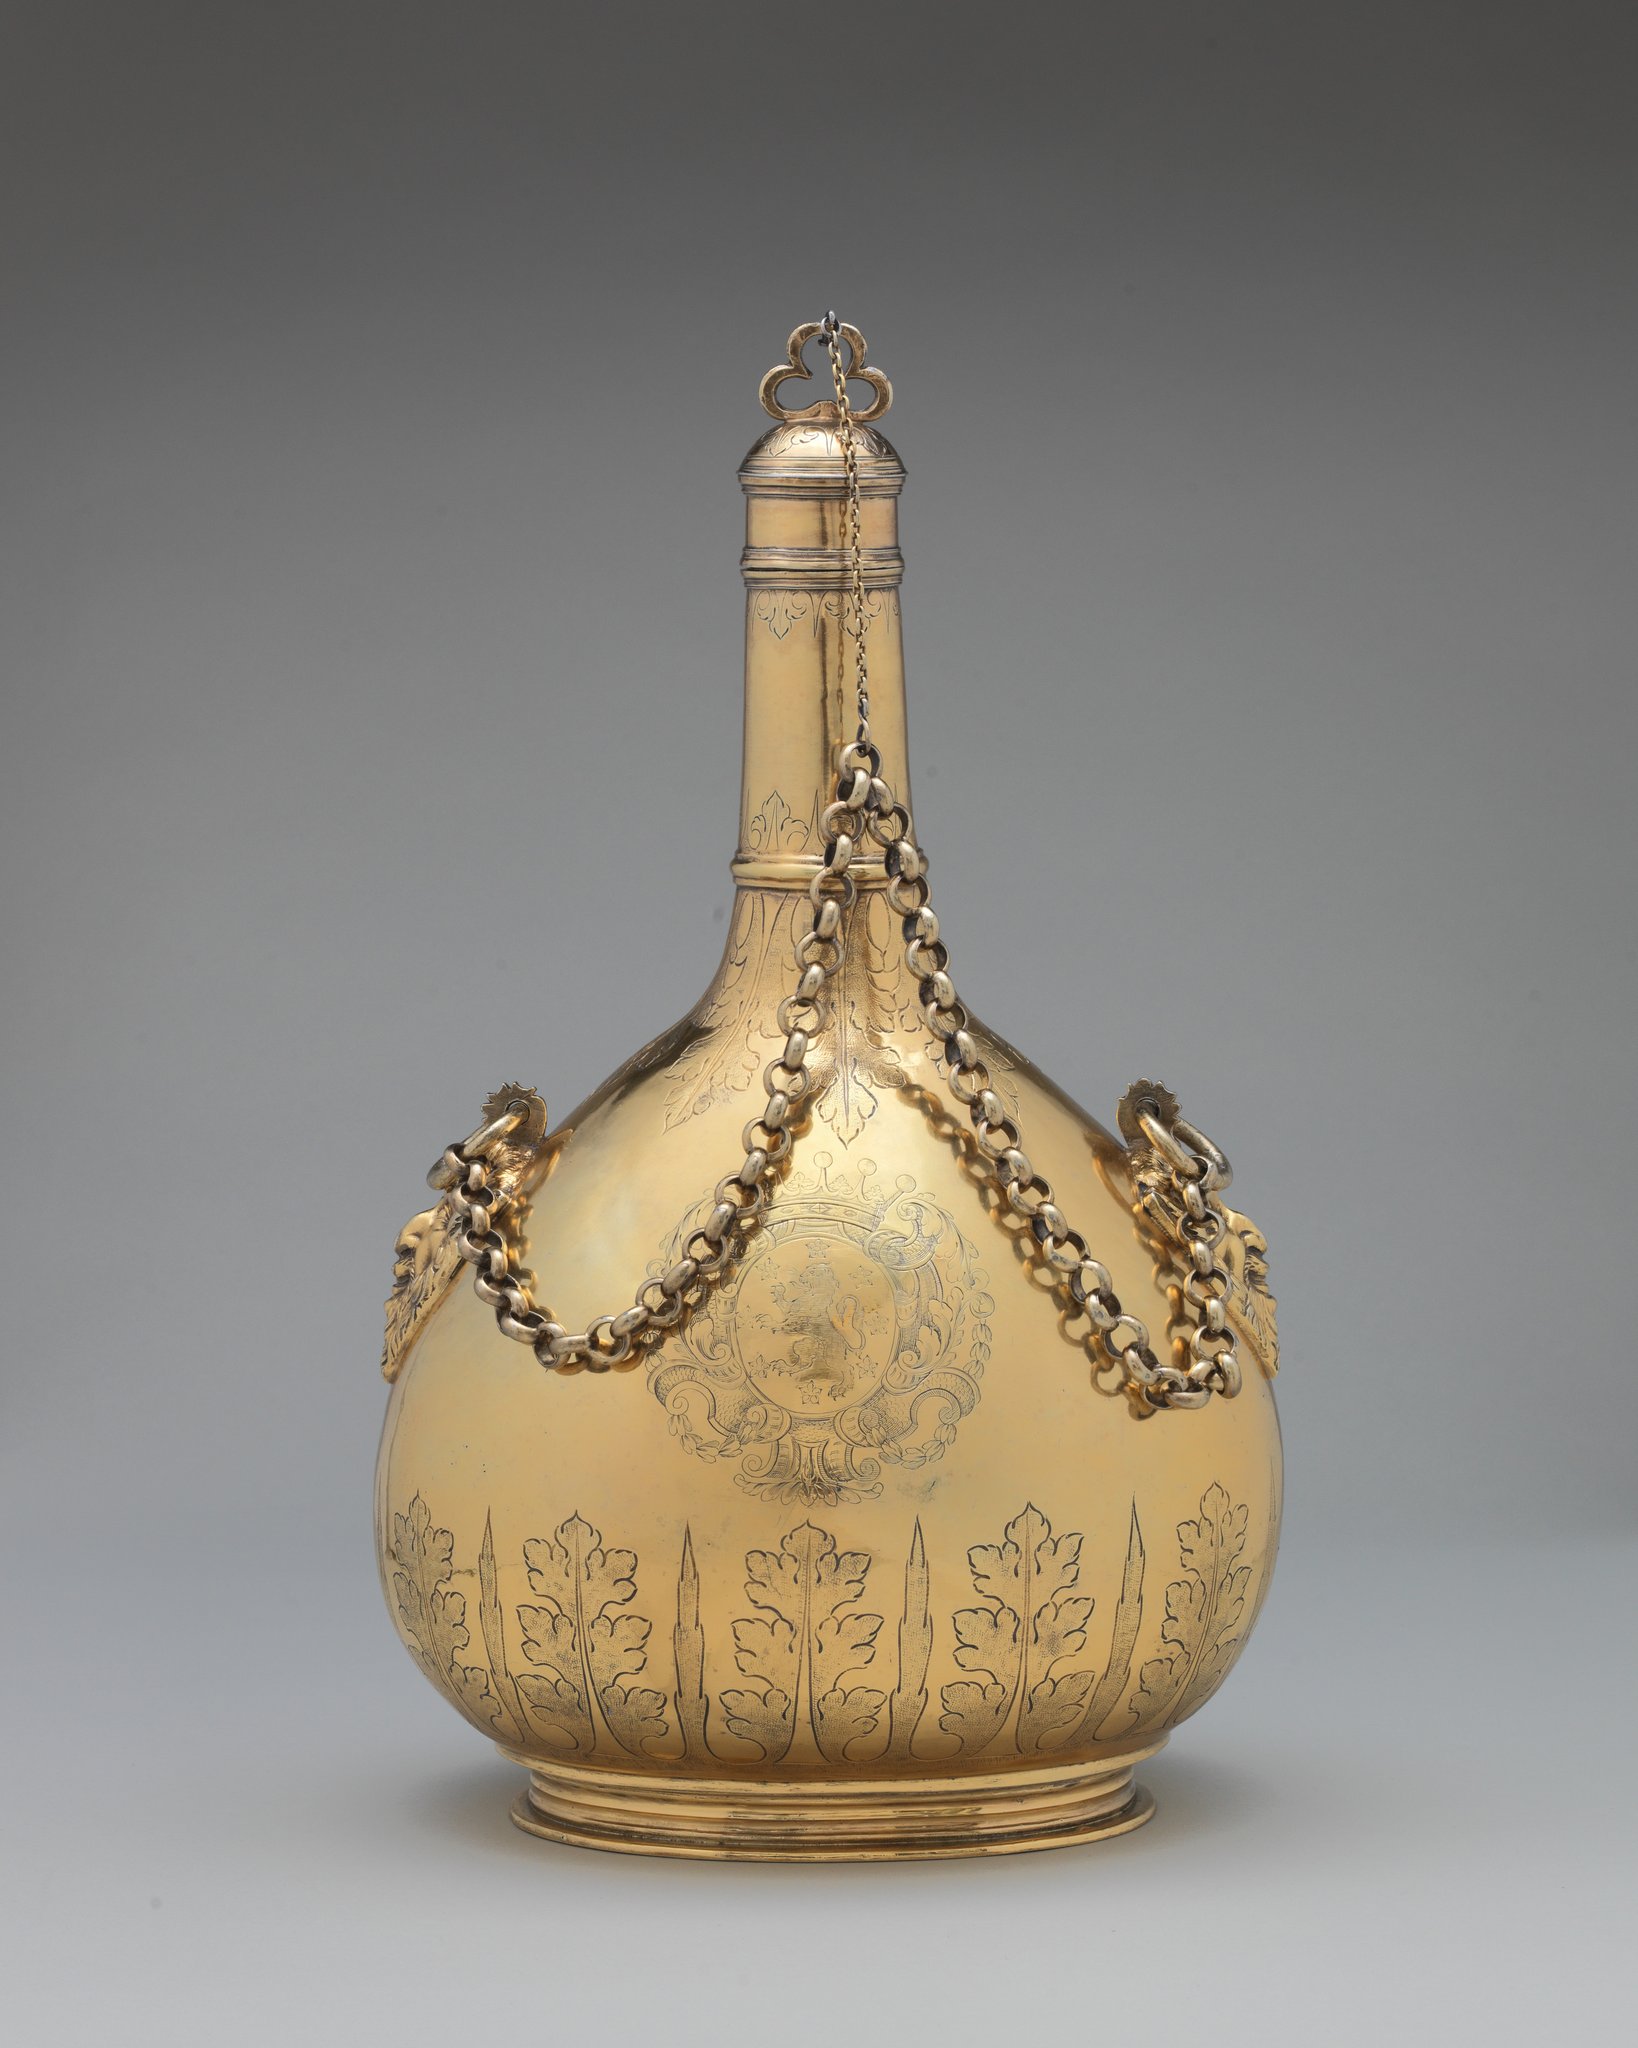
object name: pilgrim bottle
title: Pilgrim bottle (one of a pair)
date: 1690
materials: silver gilt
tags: coat of arms